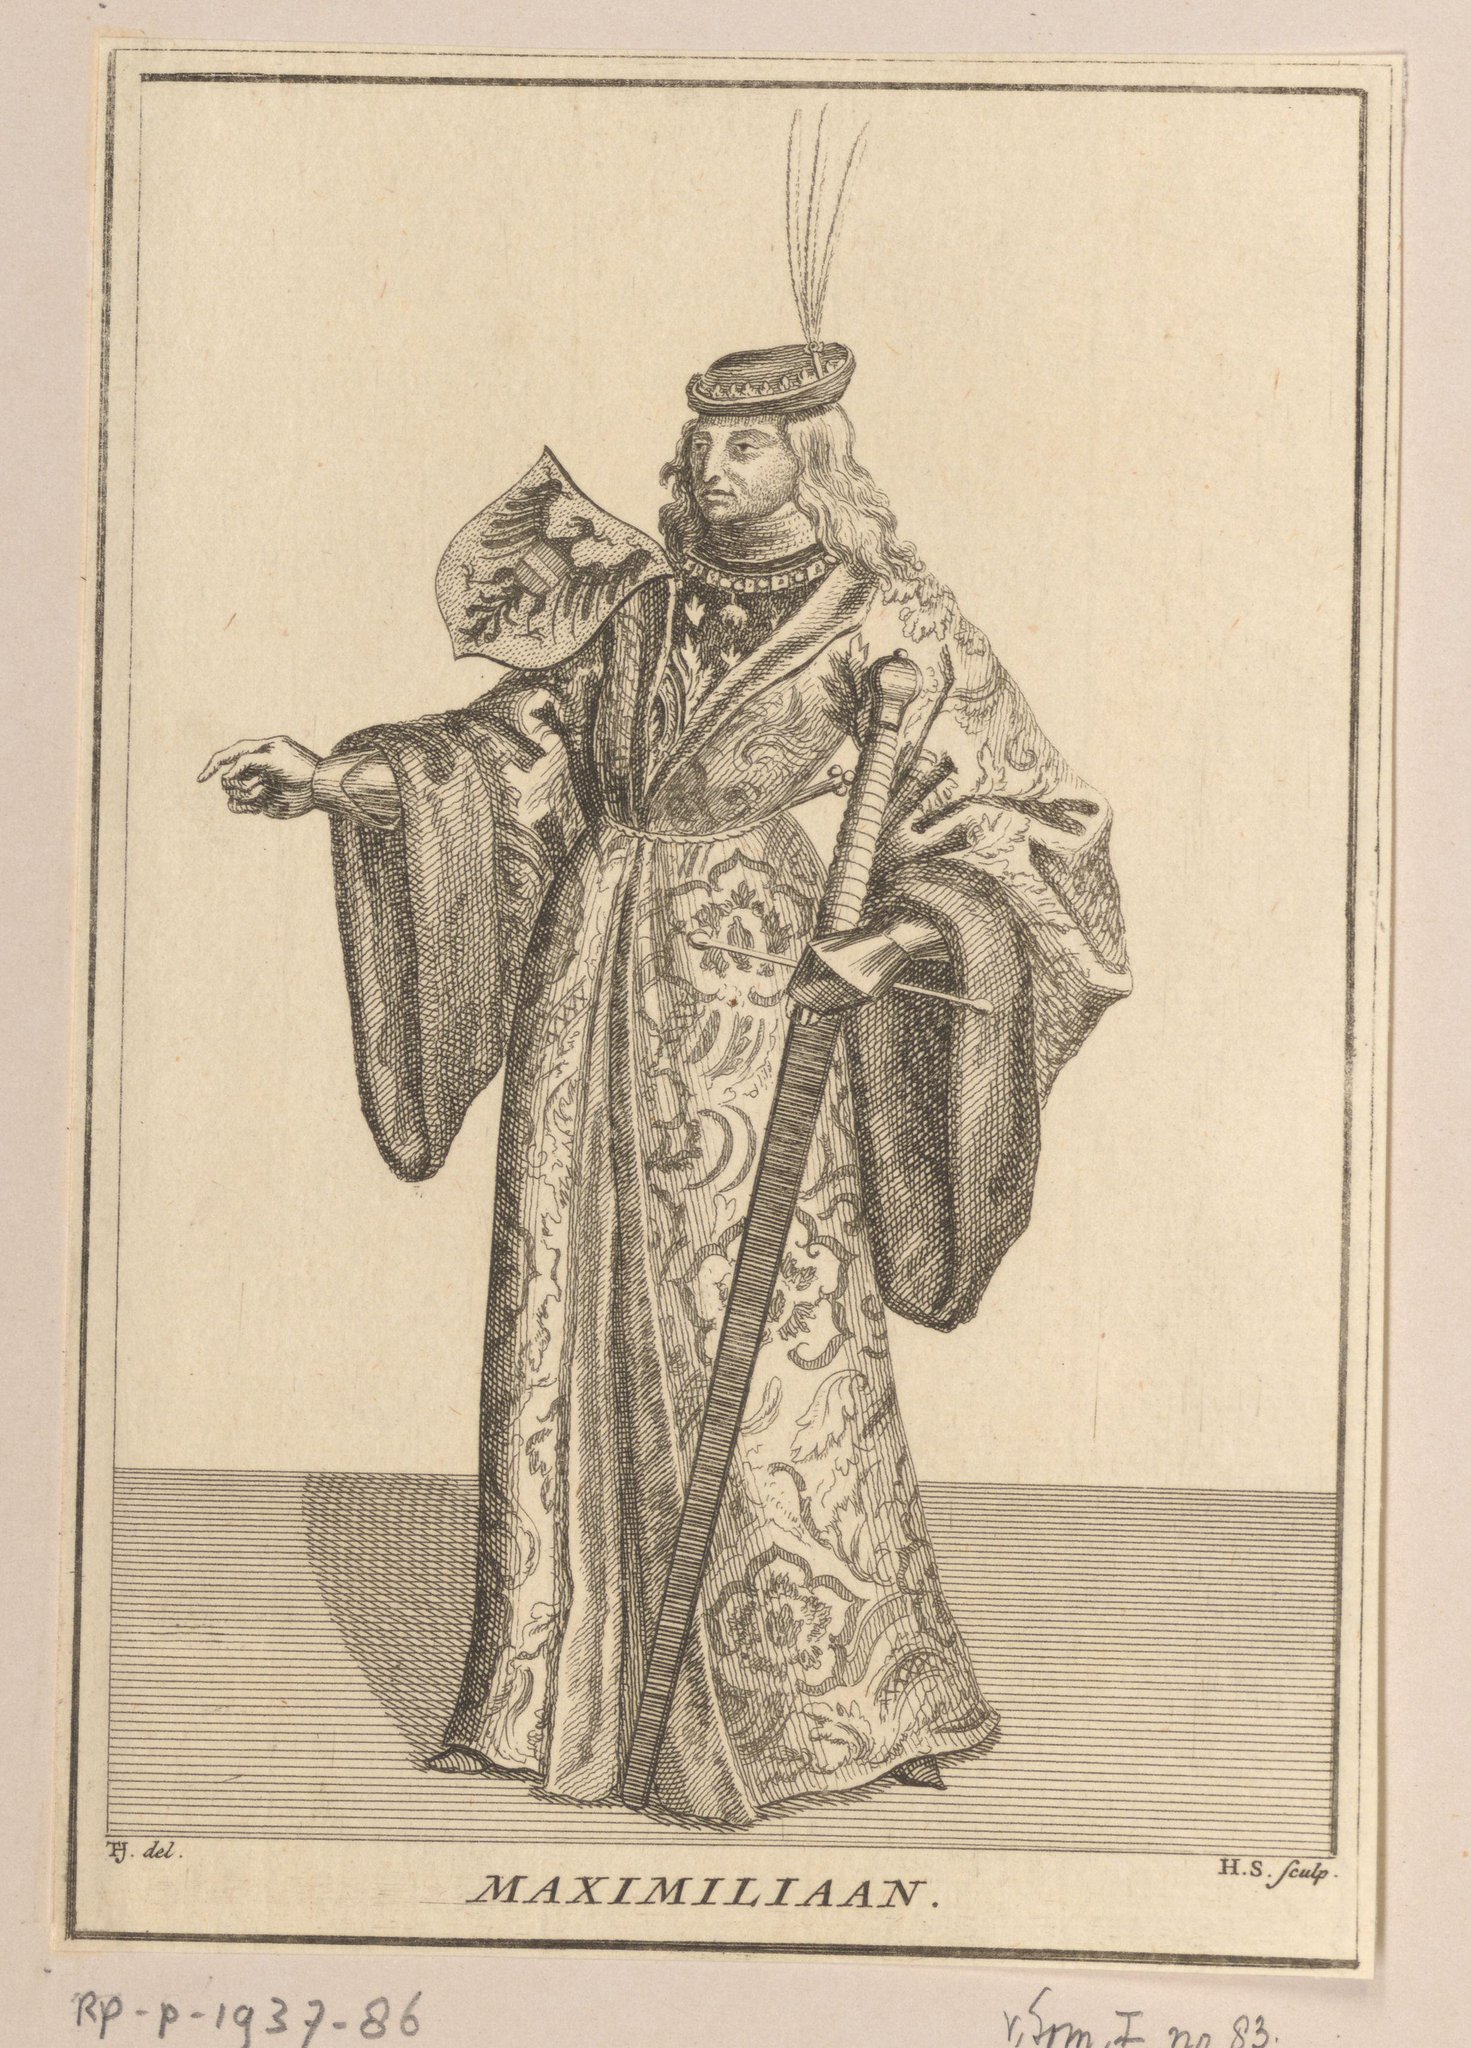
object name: print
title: Portret van keizer Maximiliaan I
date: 1745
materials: paper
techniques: etching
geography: haarlem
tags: maximilian i (holy roman emperor), historical persons, hacking and thrusting weapons: sword, emperor, armorial bearing, heraldry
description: Prent waarschijnlijk uit: Langendijk, Pieter. De Graaven van Holland, in jaardichten beschreven door Pieter Langendijk. Verrijkt met alle de beeldtenissen dier prinsen, naauwkeurig getekend naar de echte aloude tafereelen of de zaal van't raadhuis der stad Haarlem. Haarlem: J. Bosch, 1745, dl. 2.